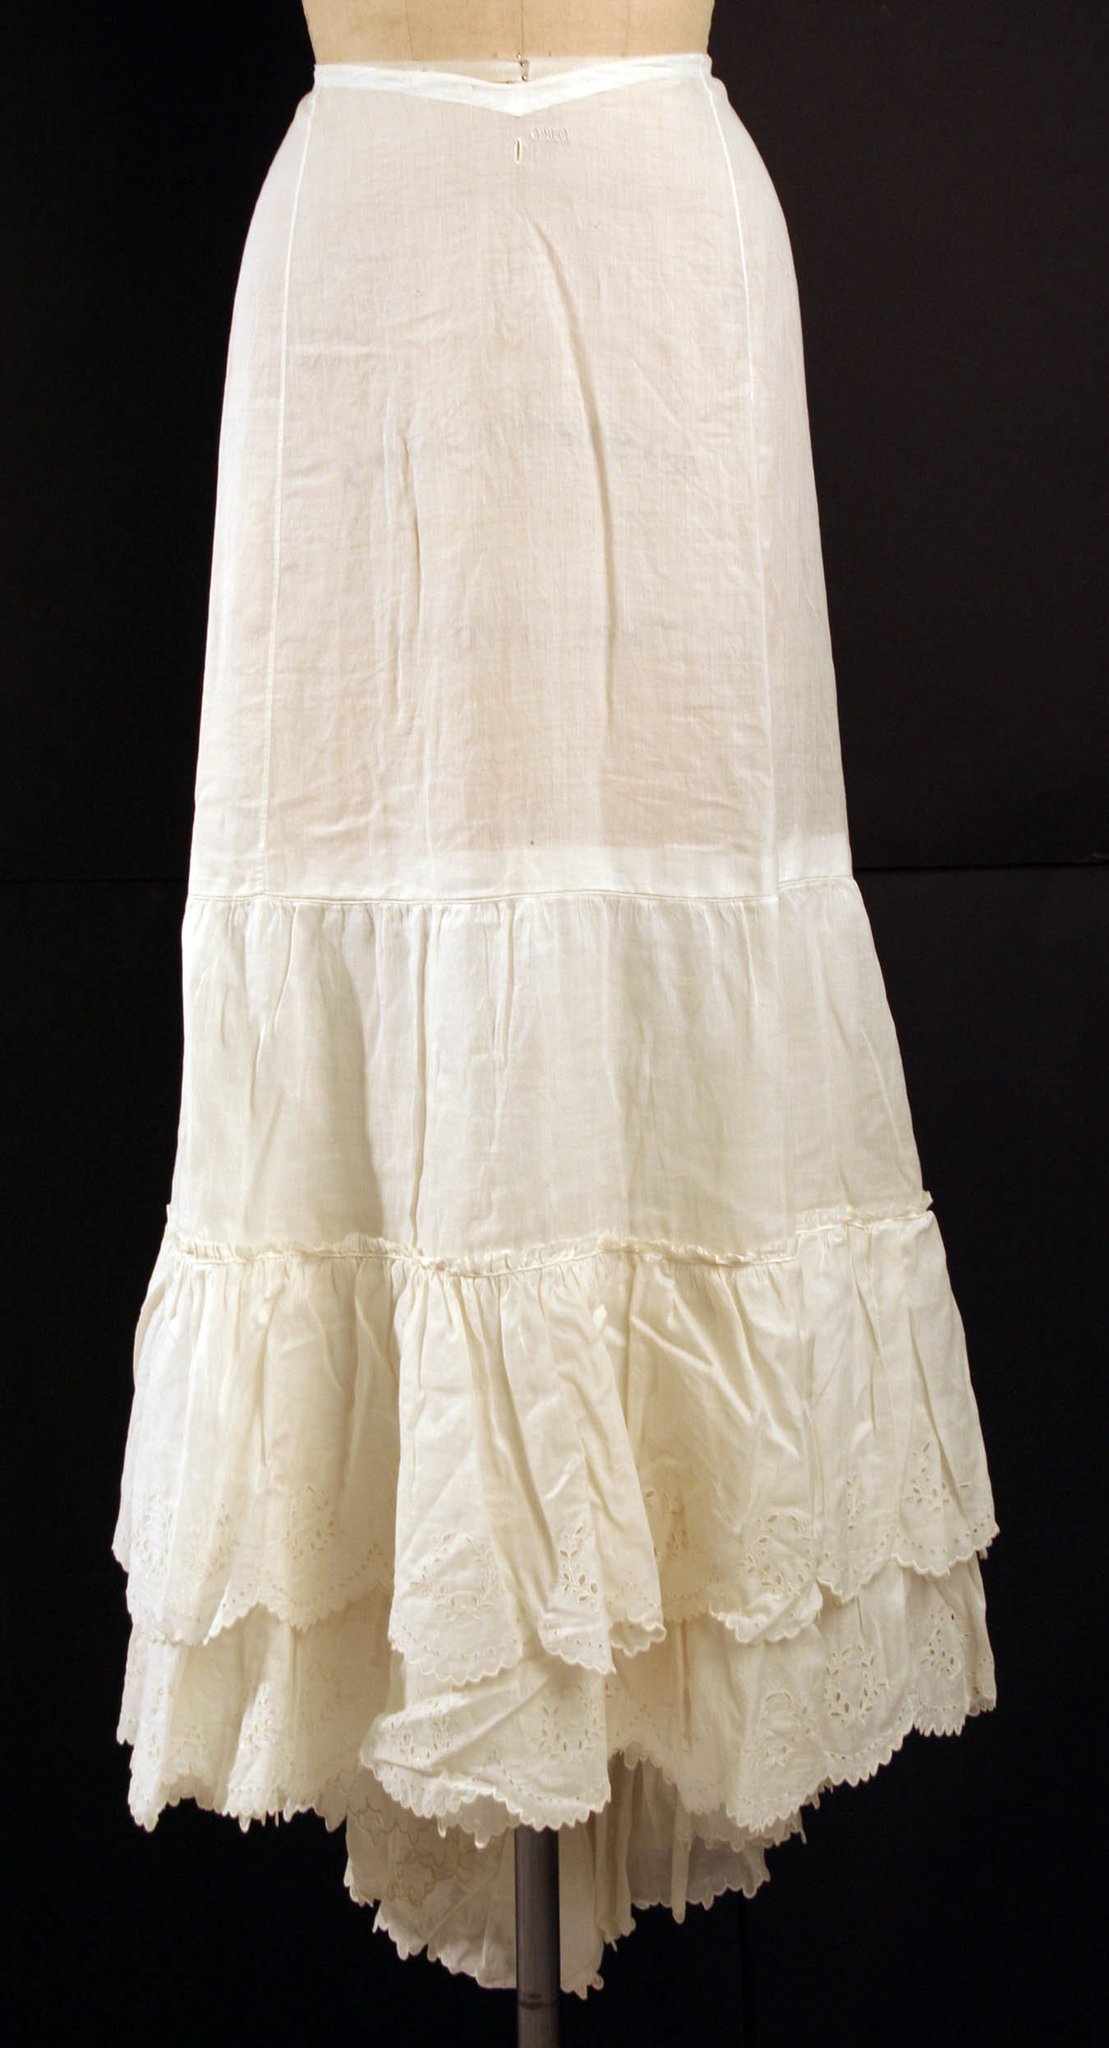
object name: underskirt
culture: american or european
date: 1875-1925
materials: cotton